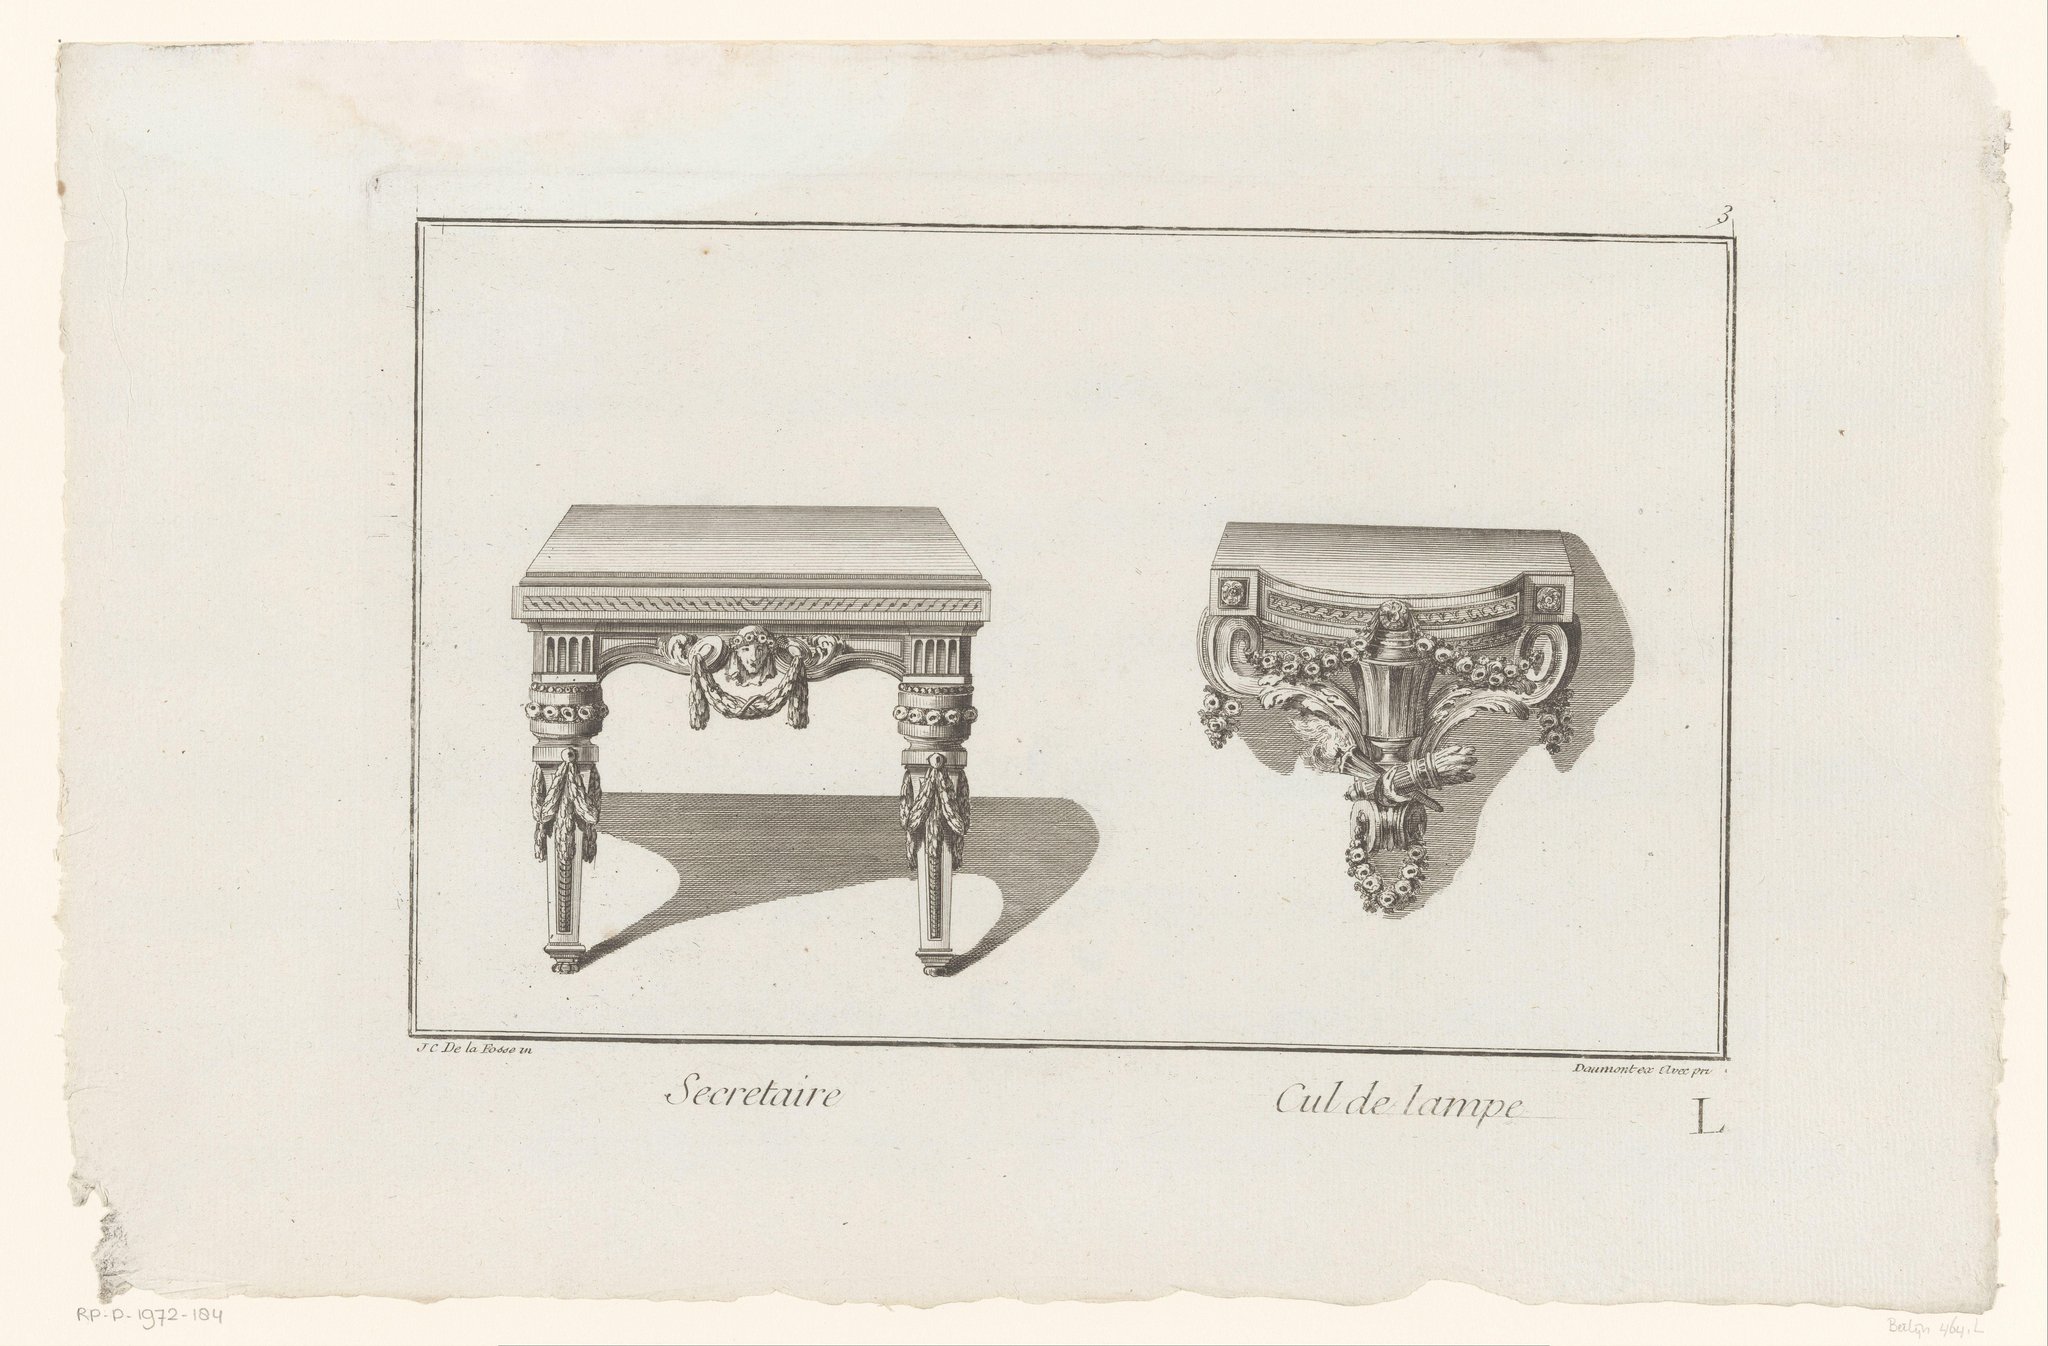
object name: ornament print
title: Tafel en cul-de-lampe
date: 1745-1775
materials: paper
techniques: engraving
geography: paris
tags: writing-table, writing-desk, other architectural details (console)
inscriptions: collector's mark: Lugt 2228, collector's mark: Lugt 2760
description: Links een (schrijf)tafel met guirlandes en een masker. Rechts een cul-de-lampe met guirlandes en fakkel en pijlenkoker.